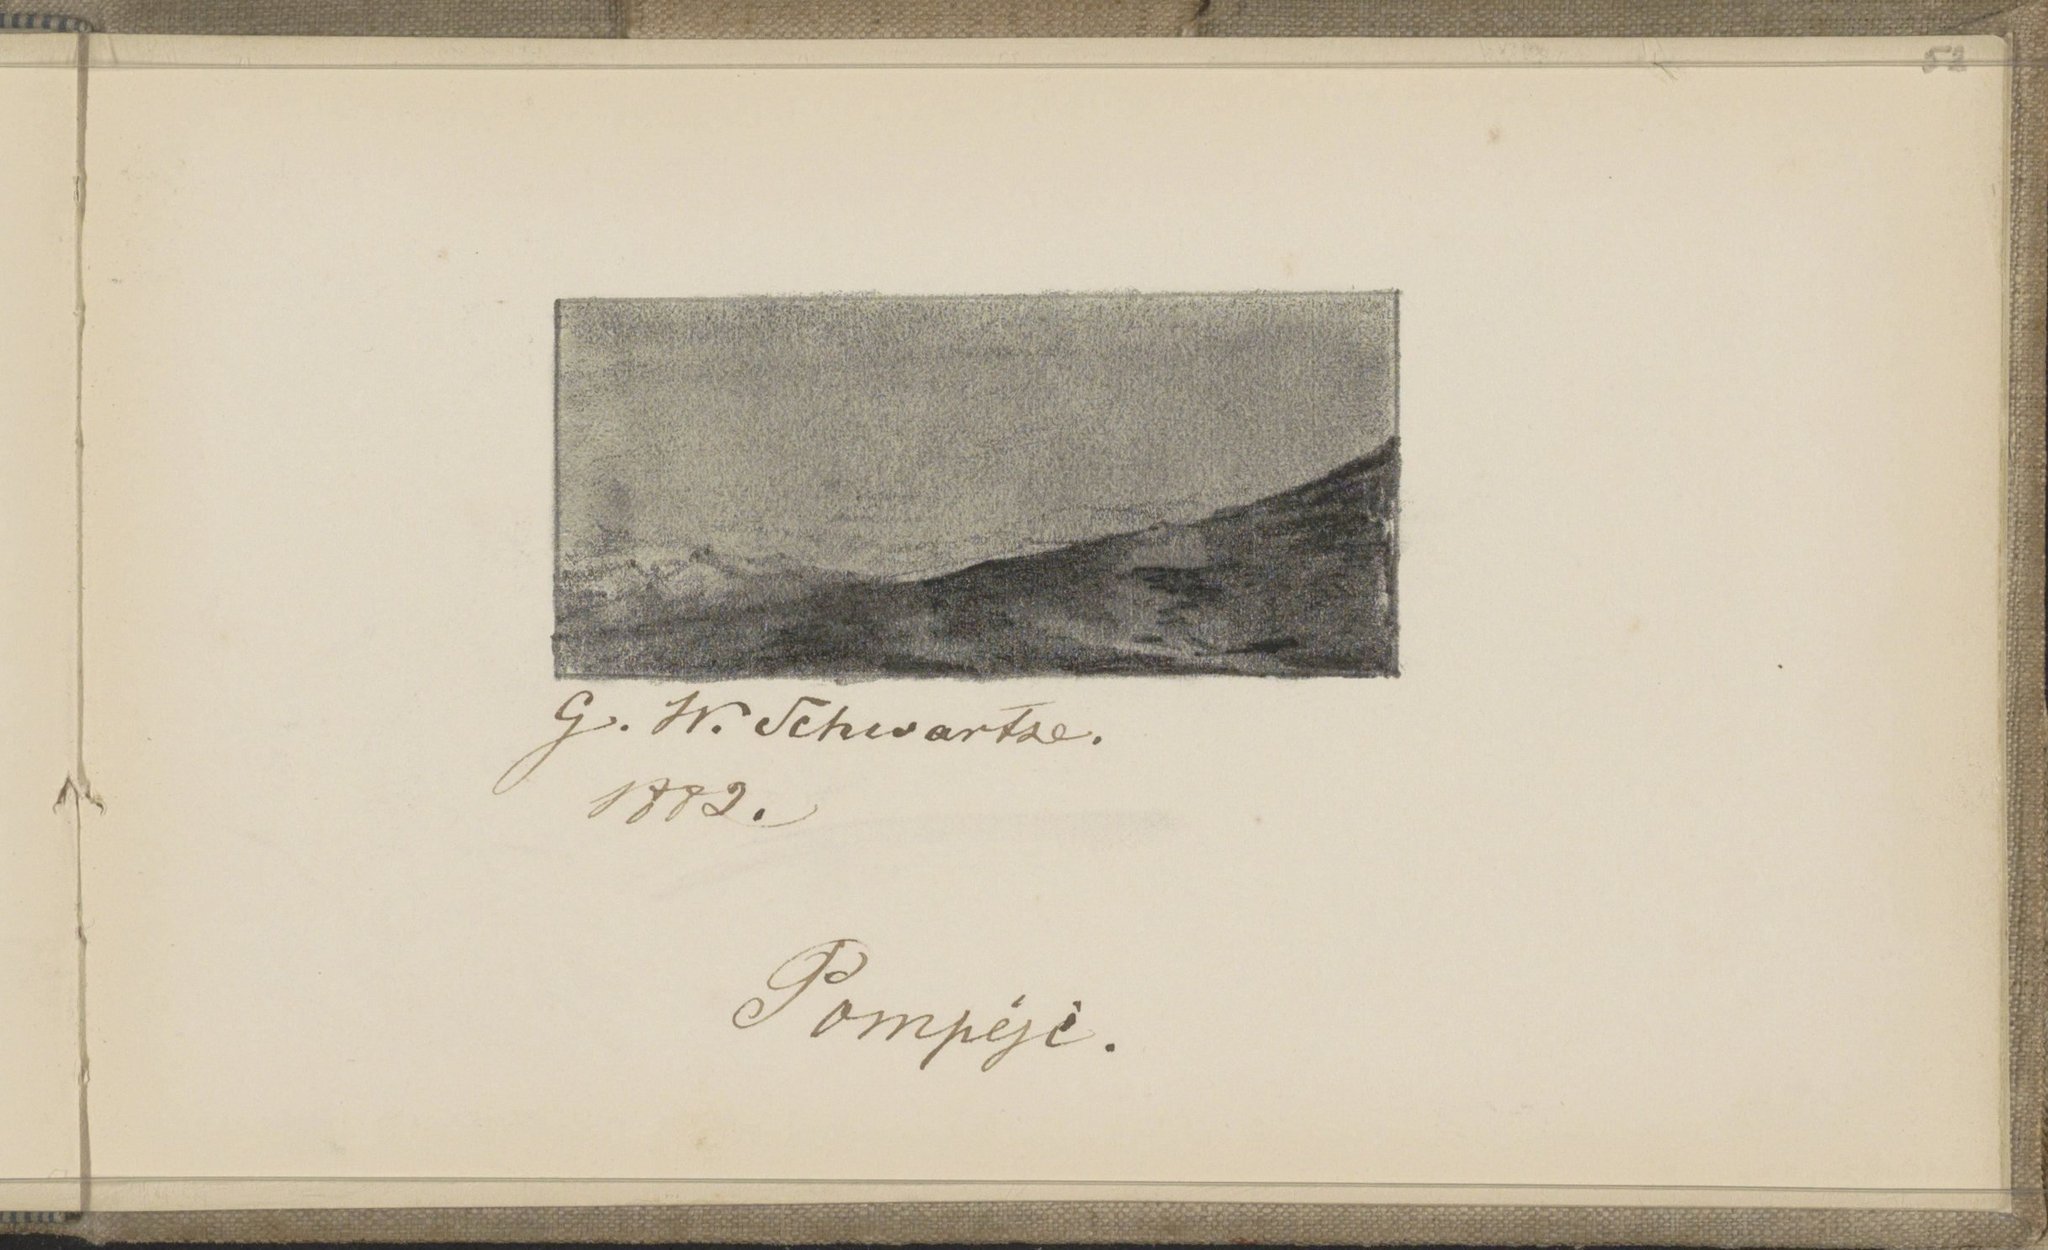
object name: sketchbook leaf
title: Gezicht op Pompeï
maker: george washington schwartze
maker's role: draughtsman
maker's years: 1857-1909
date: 1882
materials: paper, pencil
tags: city-view, and landscape with man-made constructions, mountains, pompeii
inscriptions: title: ‘Pompeji.’, signature and date: ‘G.W. Schwartze./ 1882.’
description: Tekening in een kader. Blad 52 recto uit een schetsboek met 54 bladen.